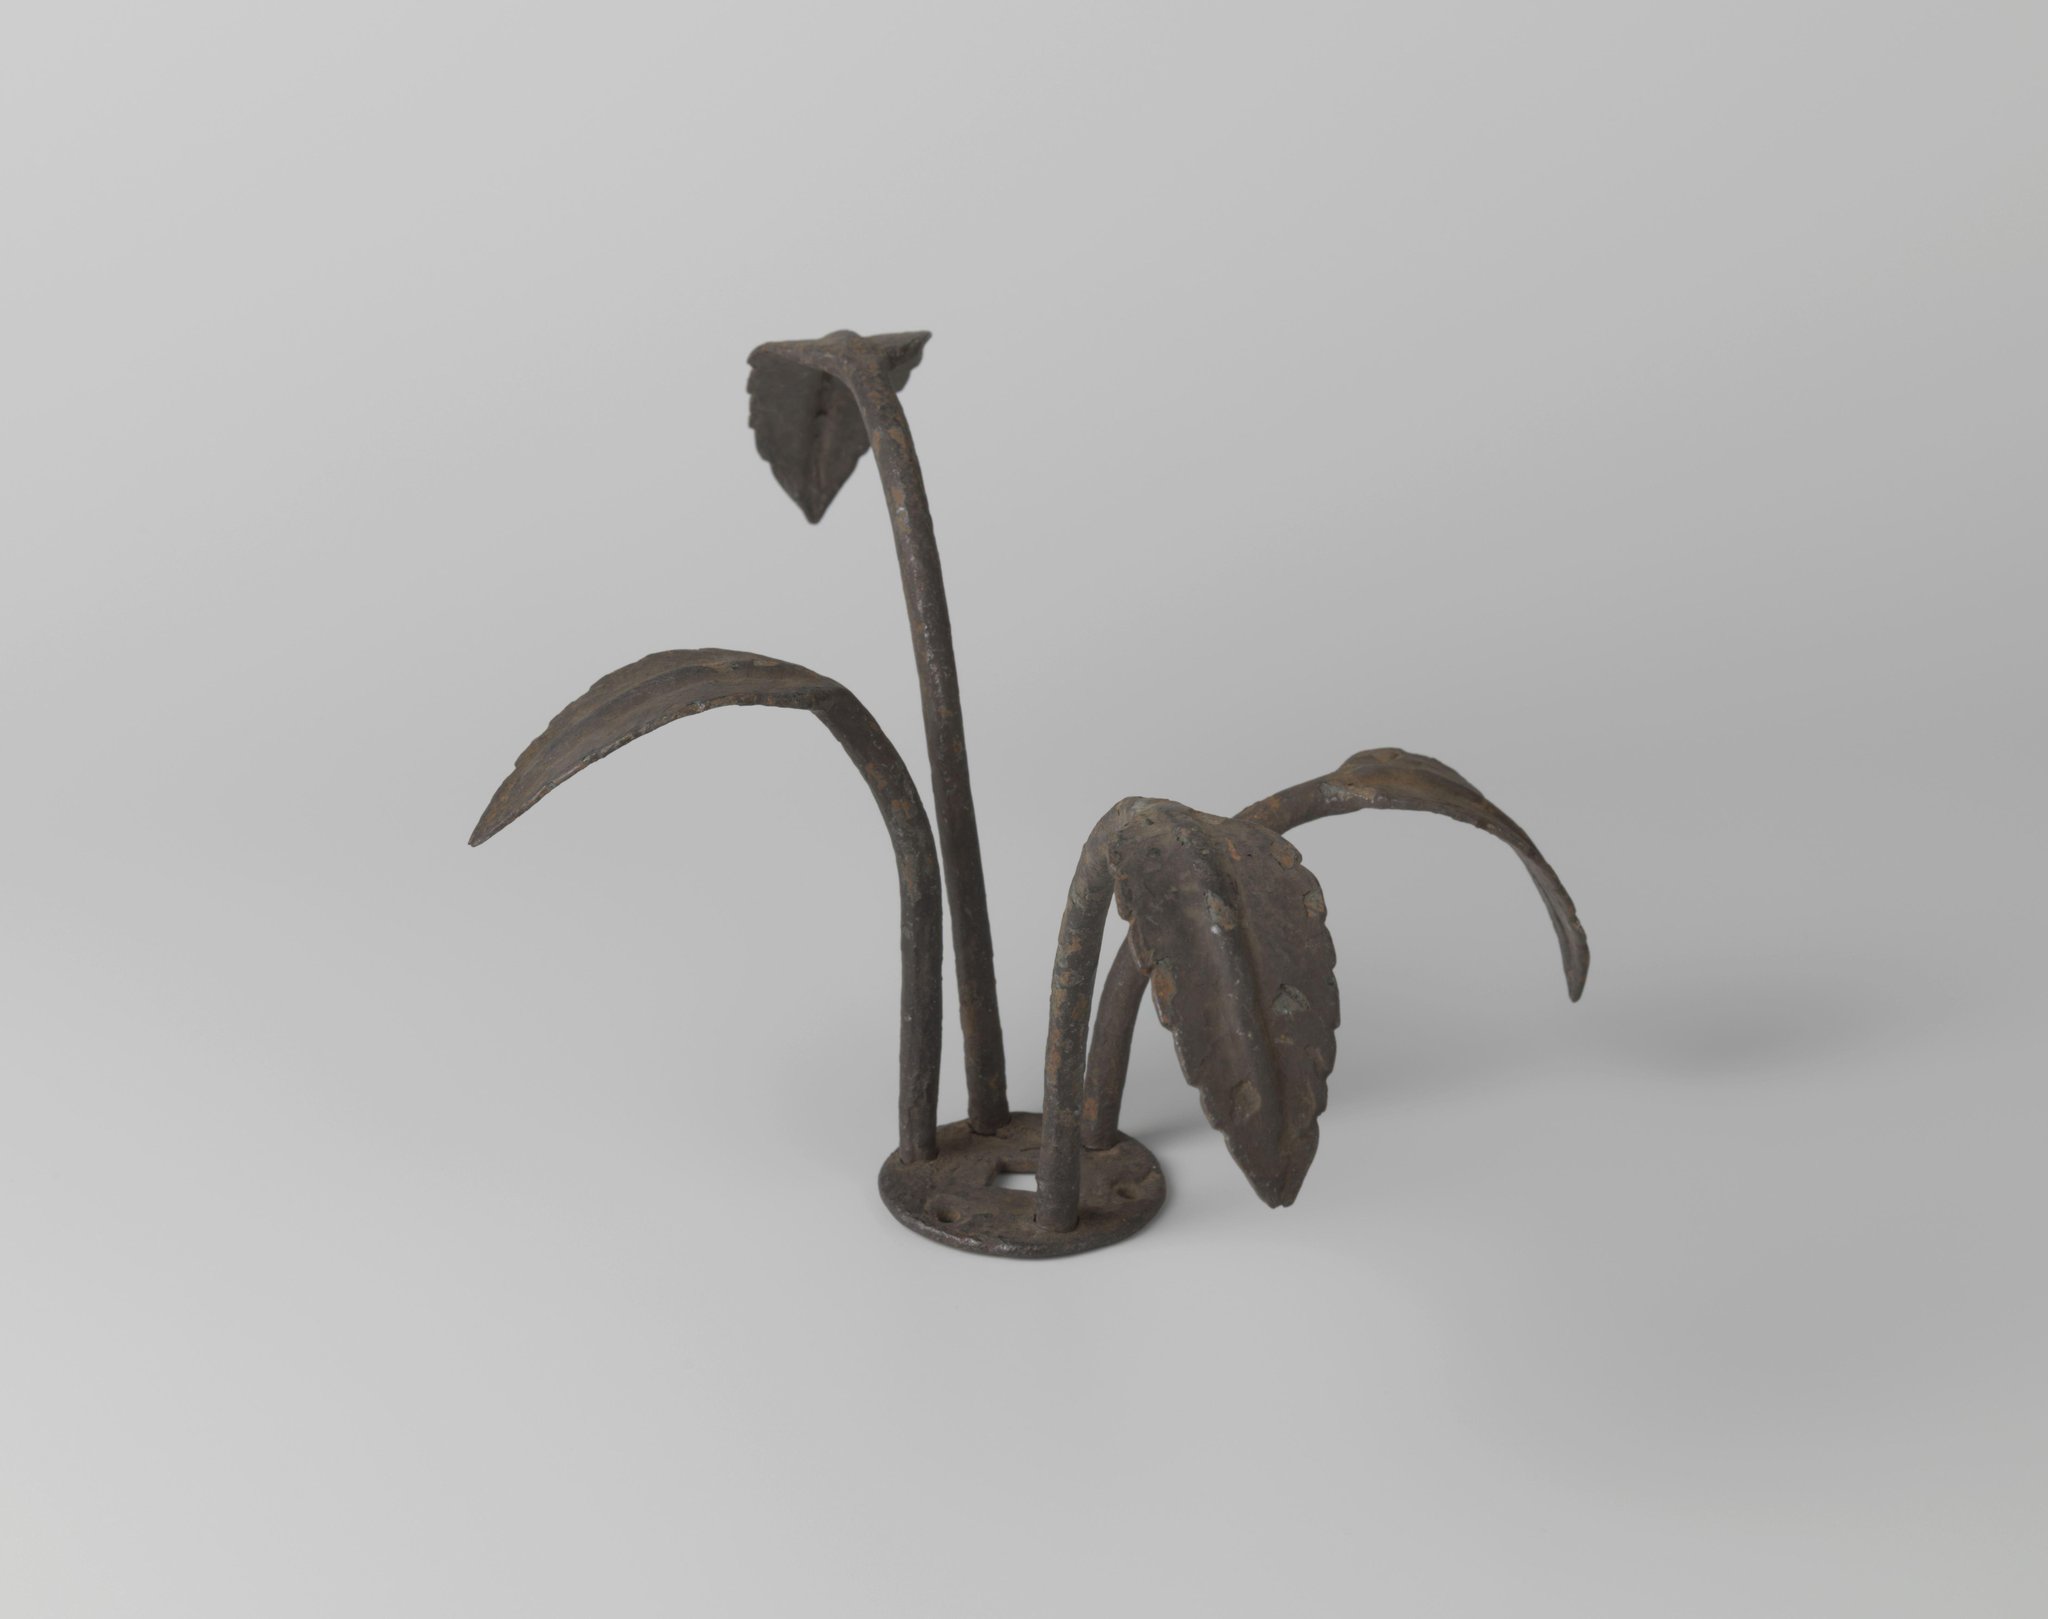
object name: festoon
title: Bloemguirlande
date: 1600-1699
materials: iron